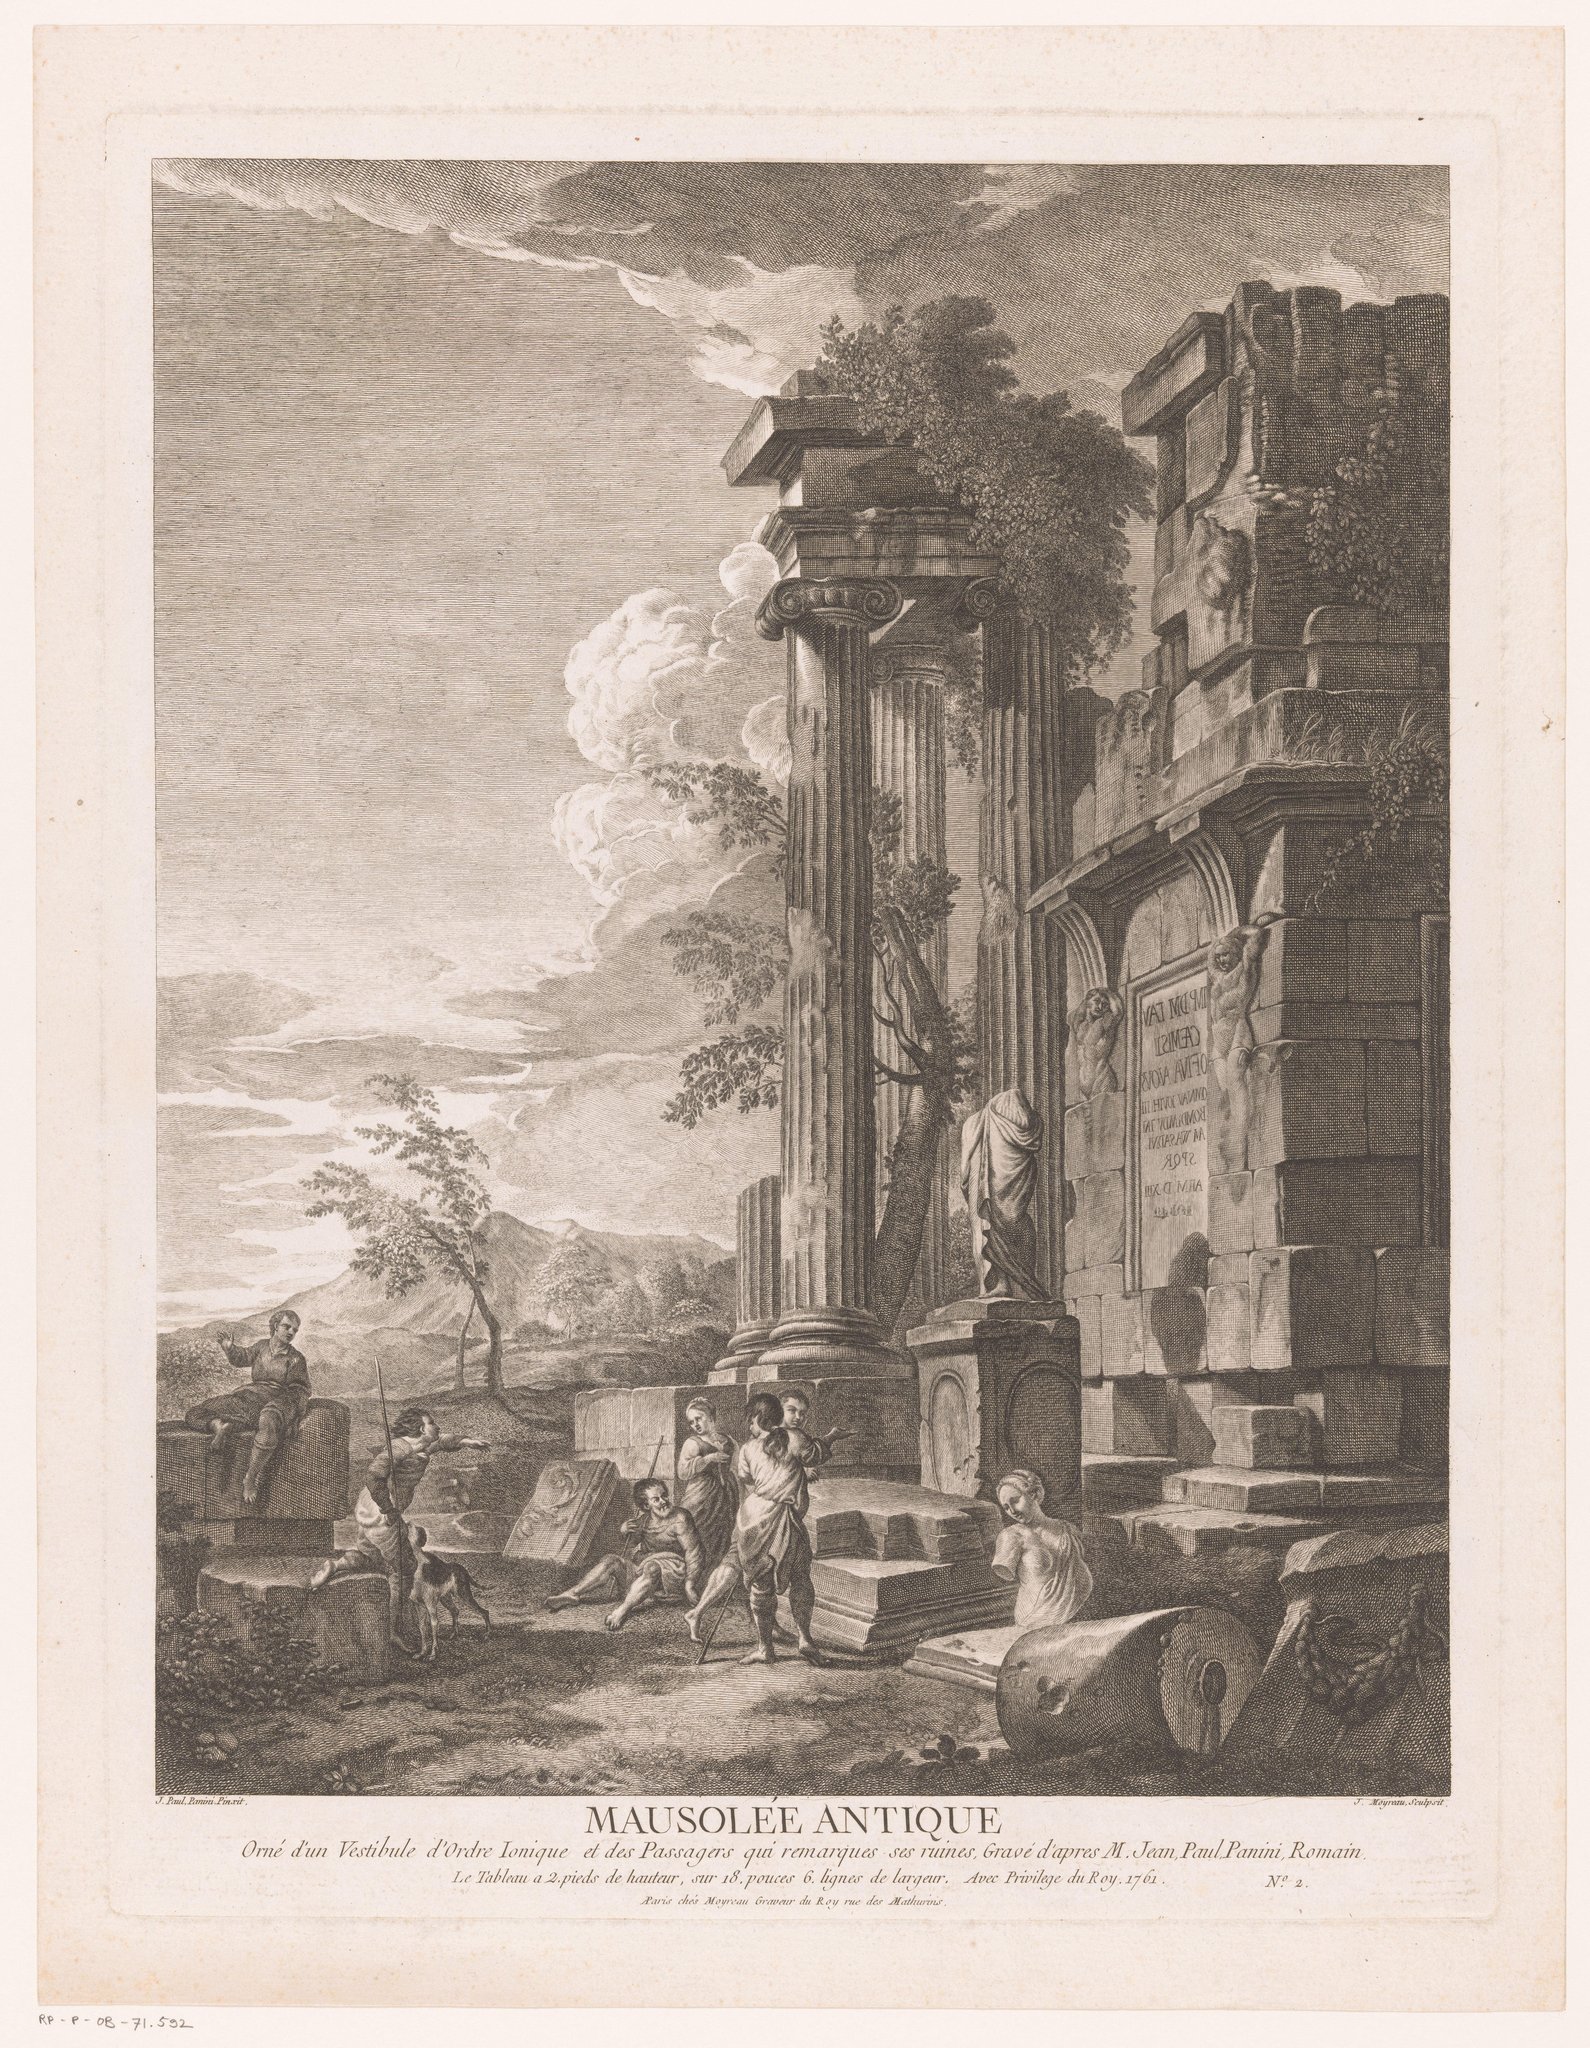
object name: print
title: Gezicht op een antieke ruïne met figuren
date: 1761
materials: paper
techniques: engraving, etching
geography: paris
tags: landscape with ruins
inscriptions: collector's mark: Lugt 2228